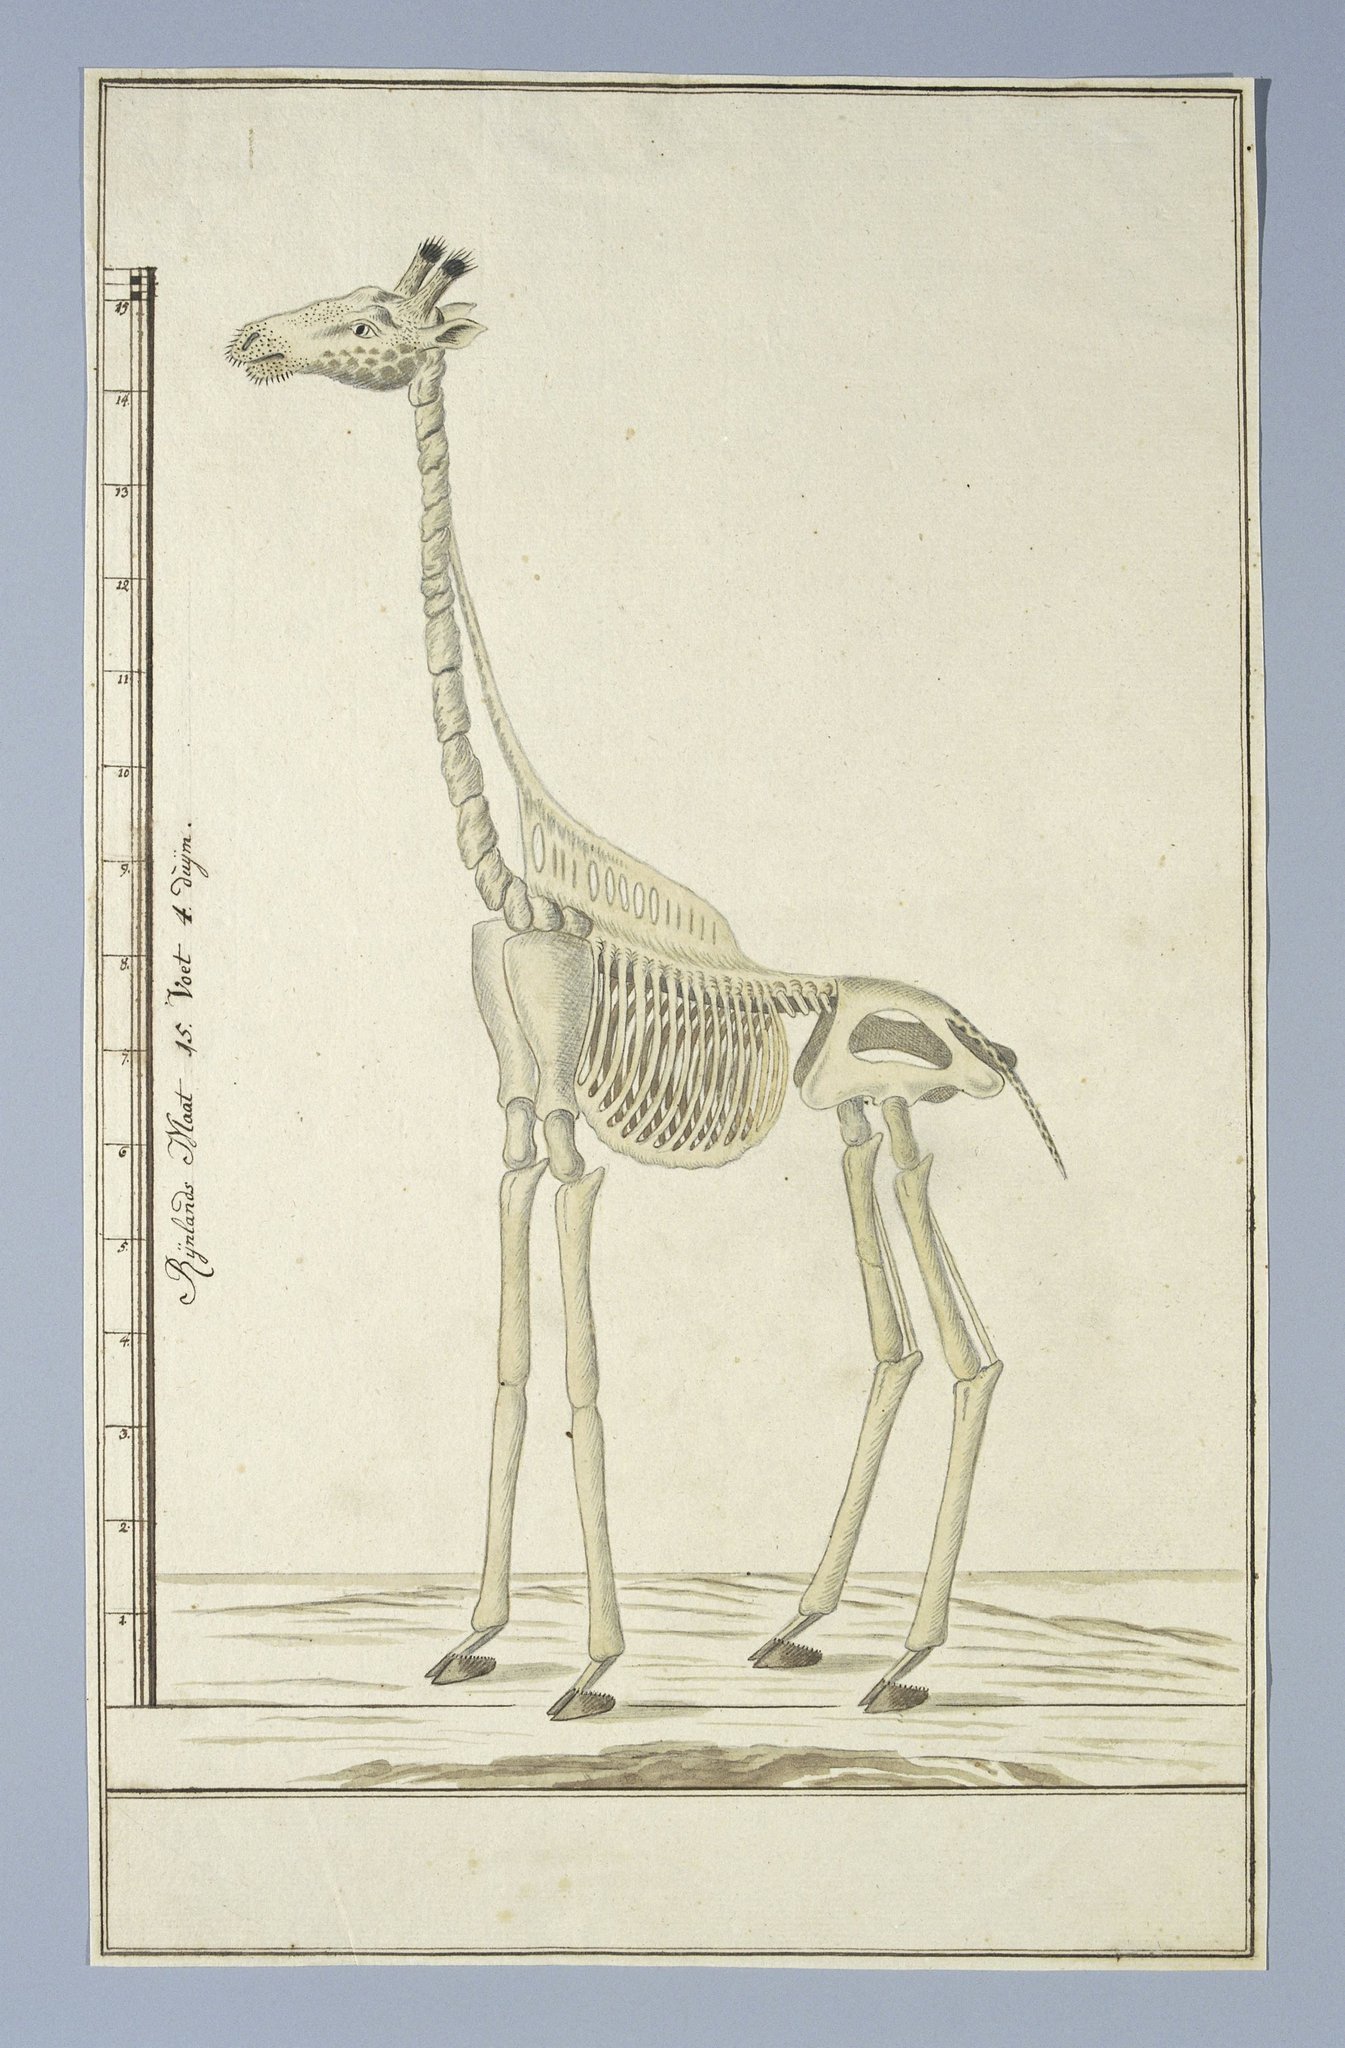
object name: drawing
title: Giraffa camelopardalis (Giraffe), skeleton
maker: robert jacob gordon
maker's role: draughtsman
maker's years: 1743-1795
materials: chalk, ink, paper, pencil, watercolor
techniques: brush, pen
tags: hoofed animals: giraffe (+ skeleton of an animal)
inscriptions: annotation: ‘schaalverdeling + Rijnlands Maat 15. Voet 4. duijm.’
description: Skelet van een giraf (Giraffa camelopardalis); met schaalverdeling in Rijnlandse maat.